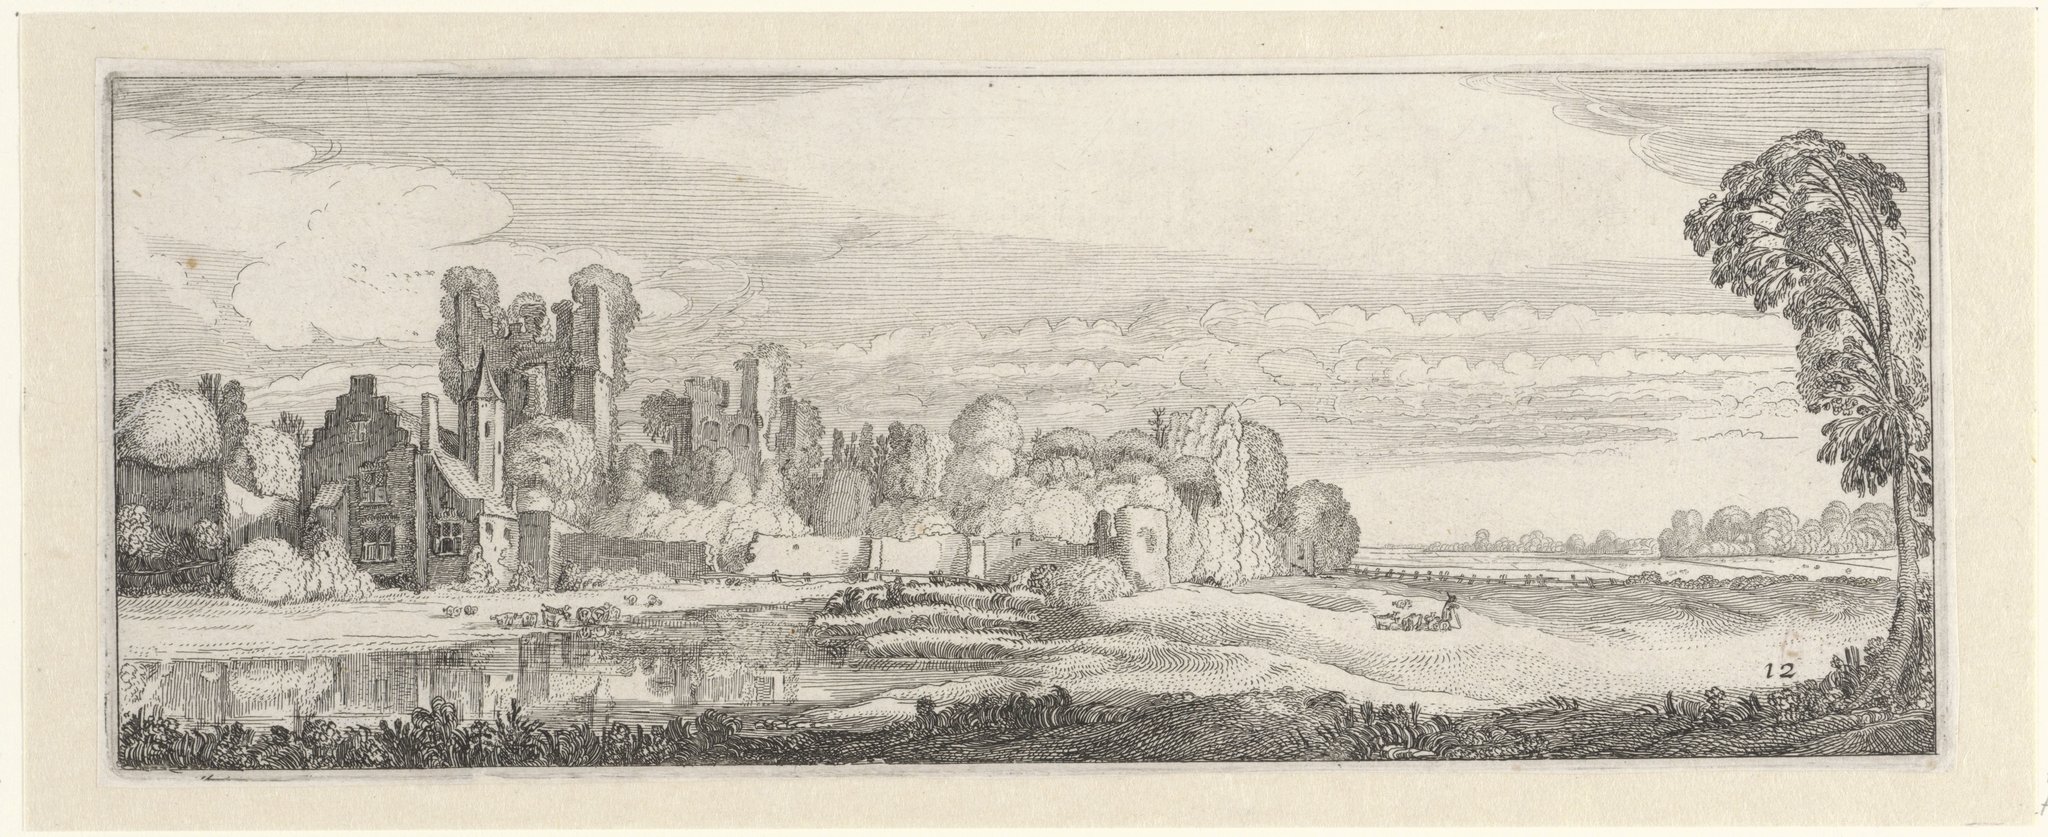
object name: print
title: Huis ter Kleef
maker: jan van de velde (ii)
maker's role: draughtsman, painter, print maker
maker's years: 1593-1641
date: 1615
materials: paper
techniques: etching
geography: northern netherlands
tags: meadow, pasture, landscape with ruins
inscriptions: collector's mark: Lugt 240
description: Gezicht op de ruïne huis ter Kleef. Twaalfde prent uit een serie van achttien.